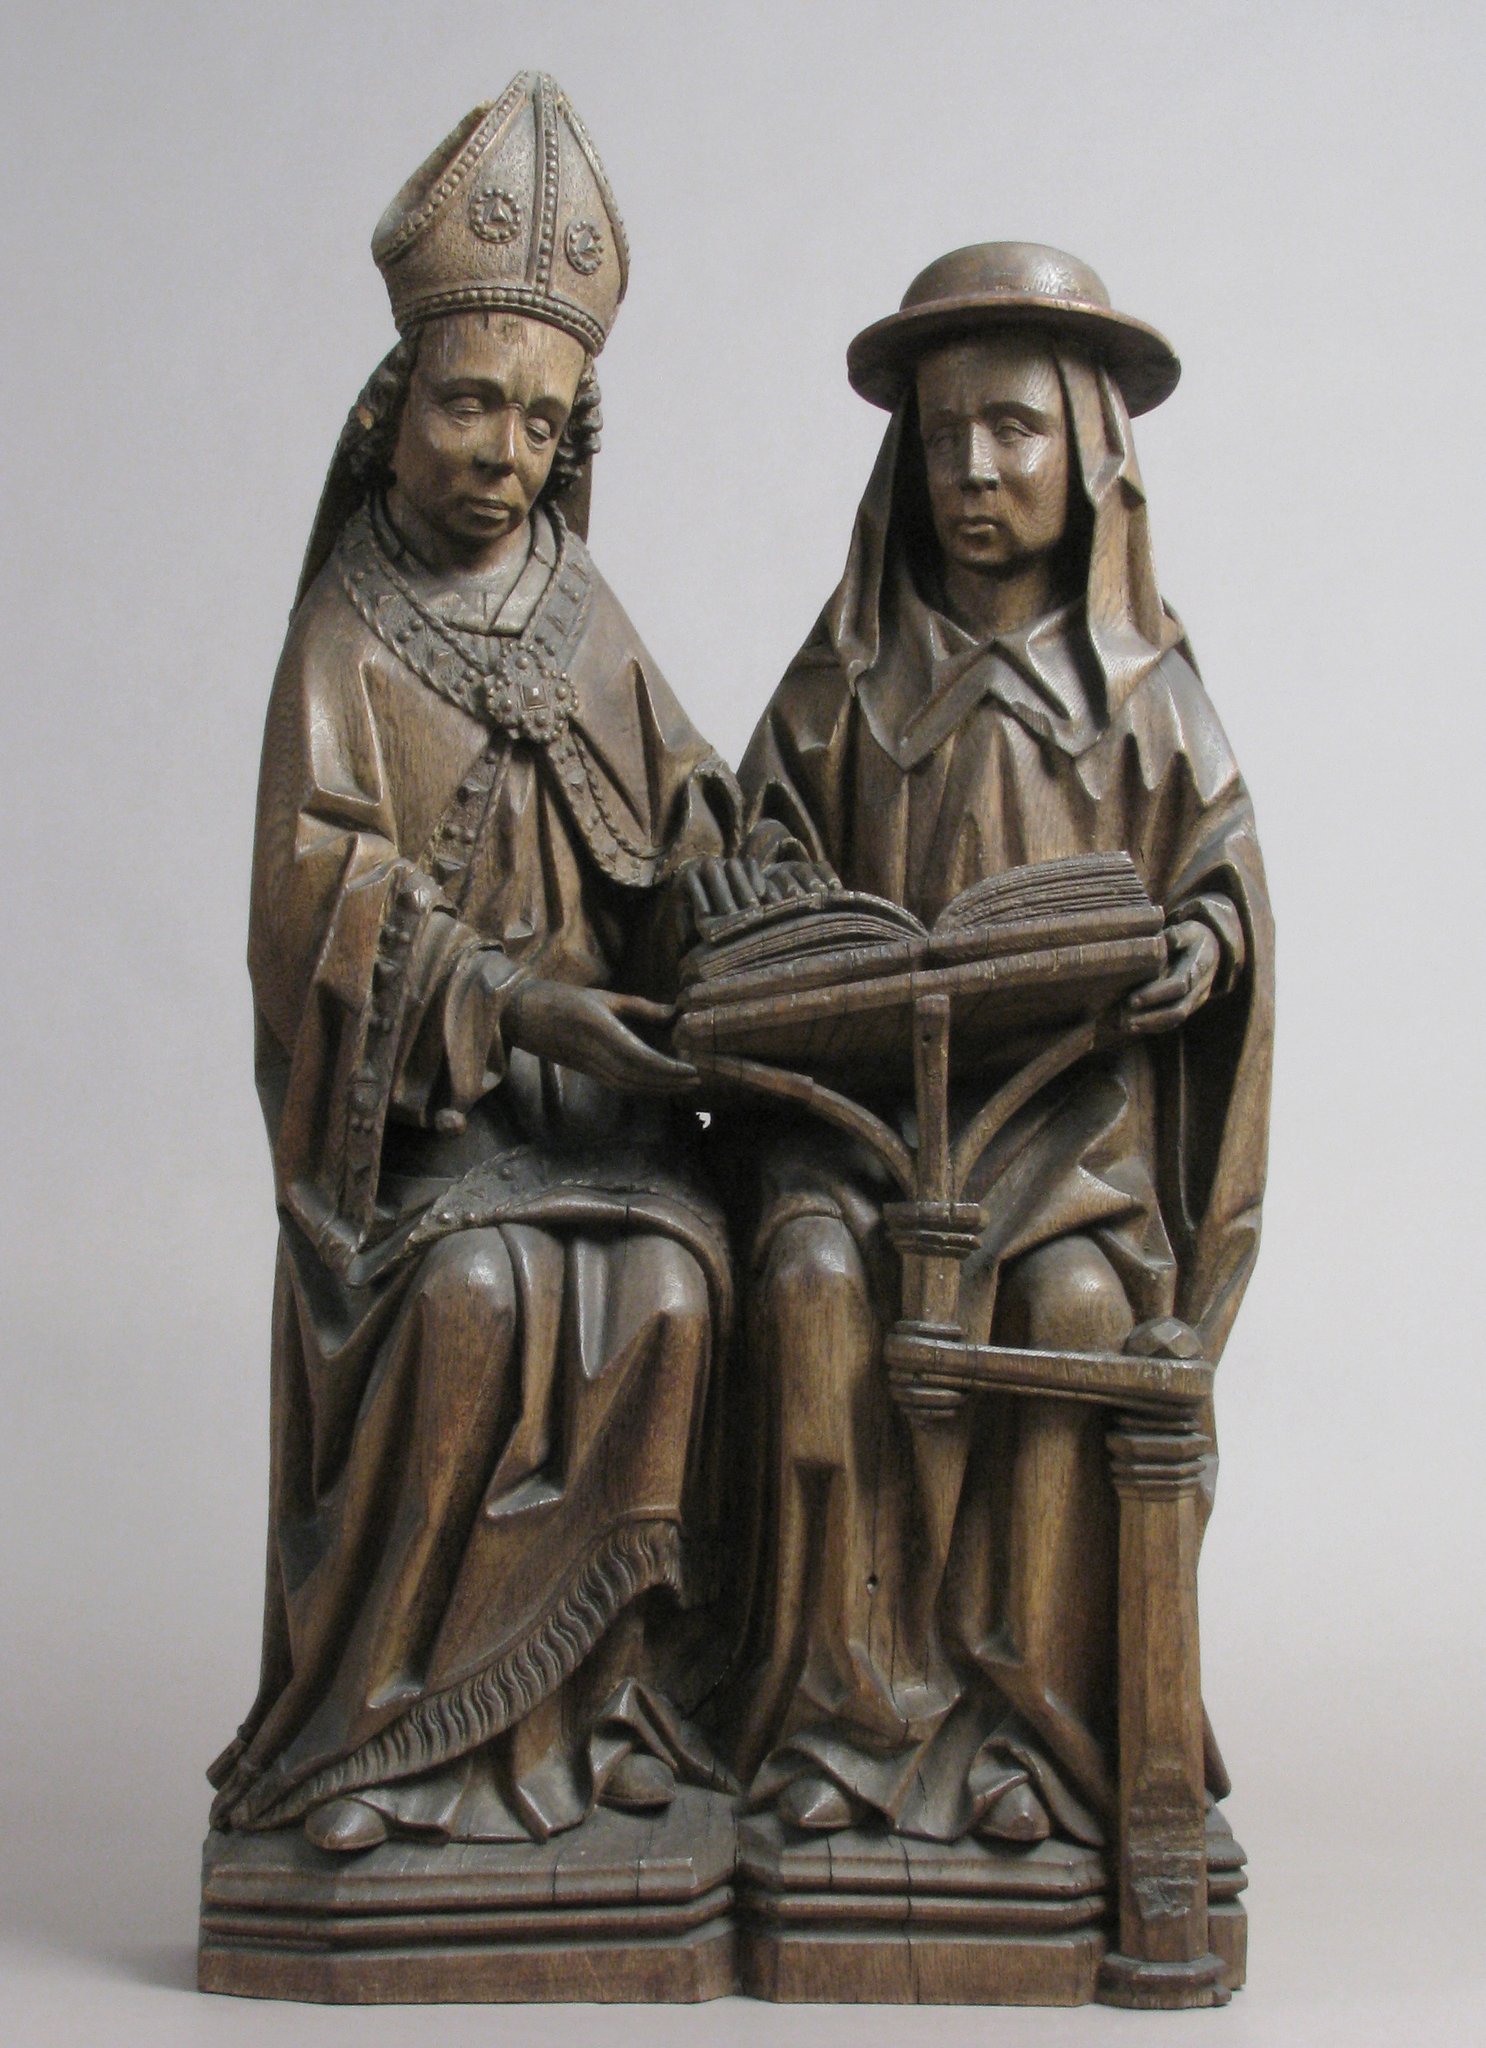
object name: statuette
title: St. Augustine (or St. Ambrose) and St. Jerome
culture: german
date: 1501-1533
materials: wood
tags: saints